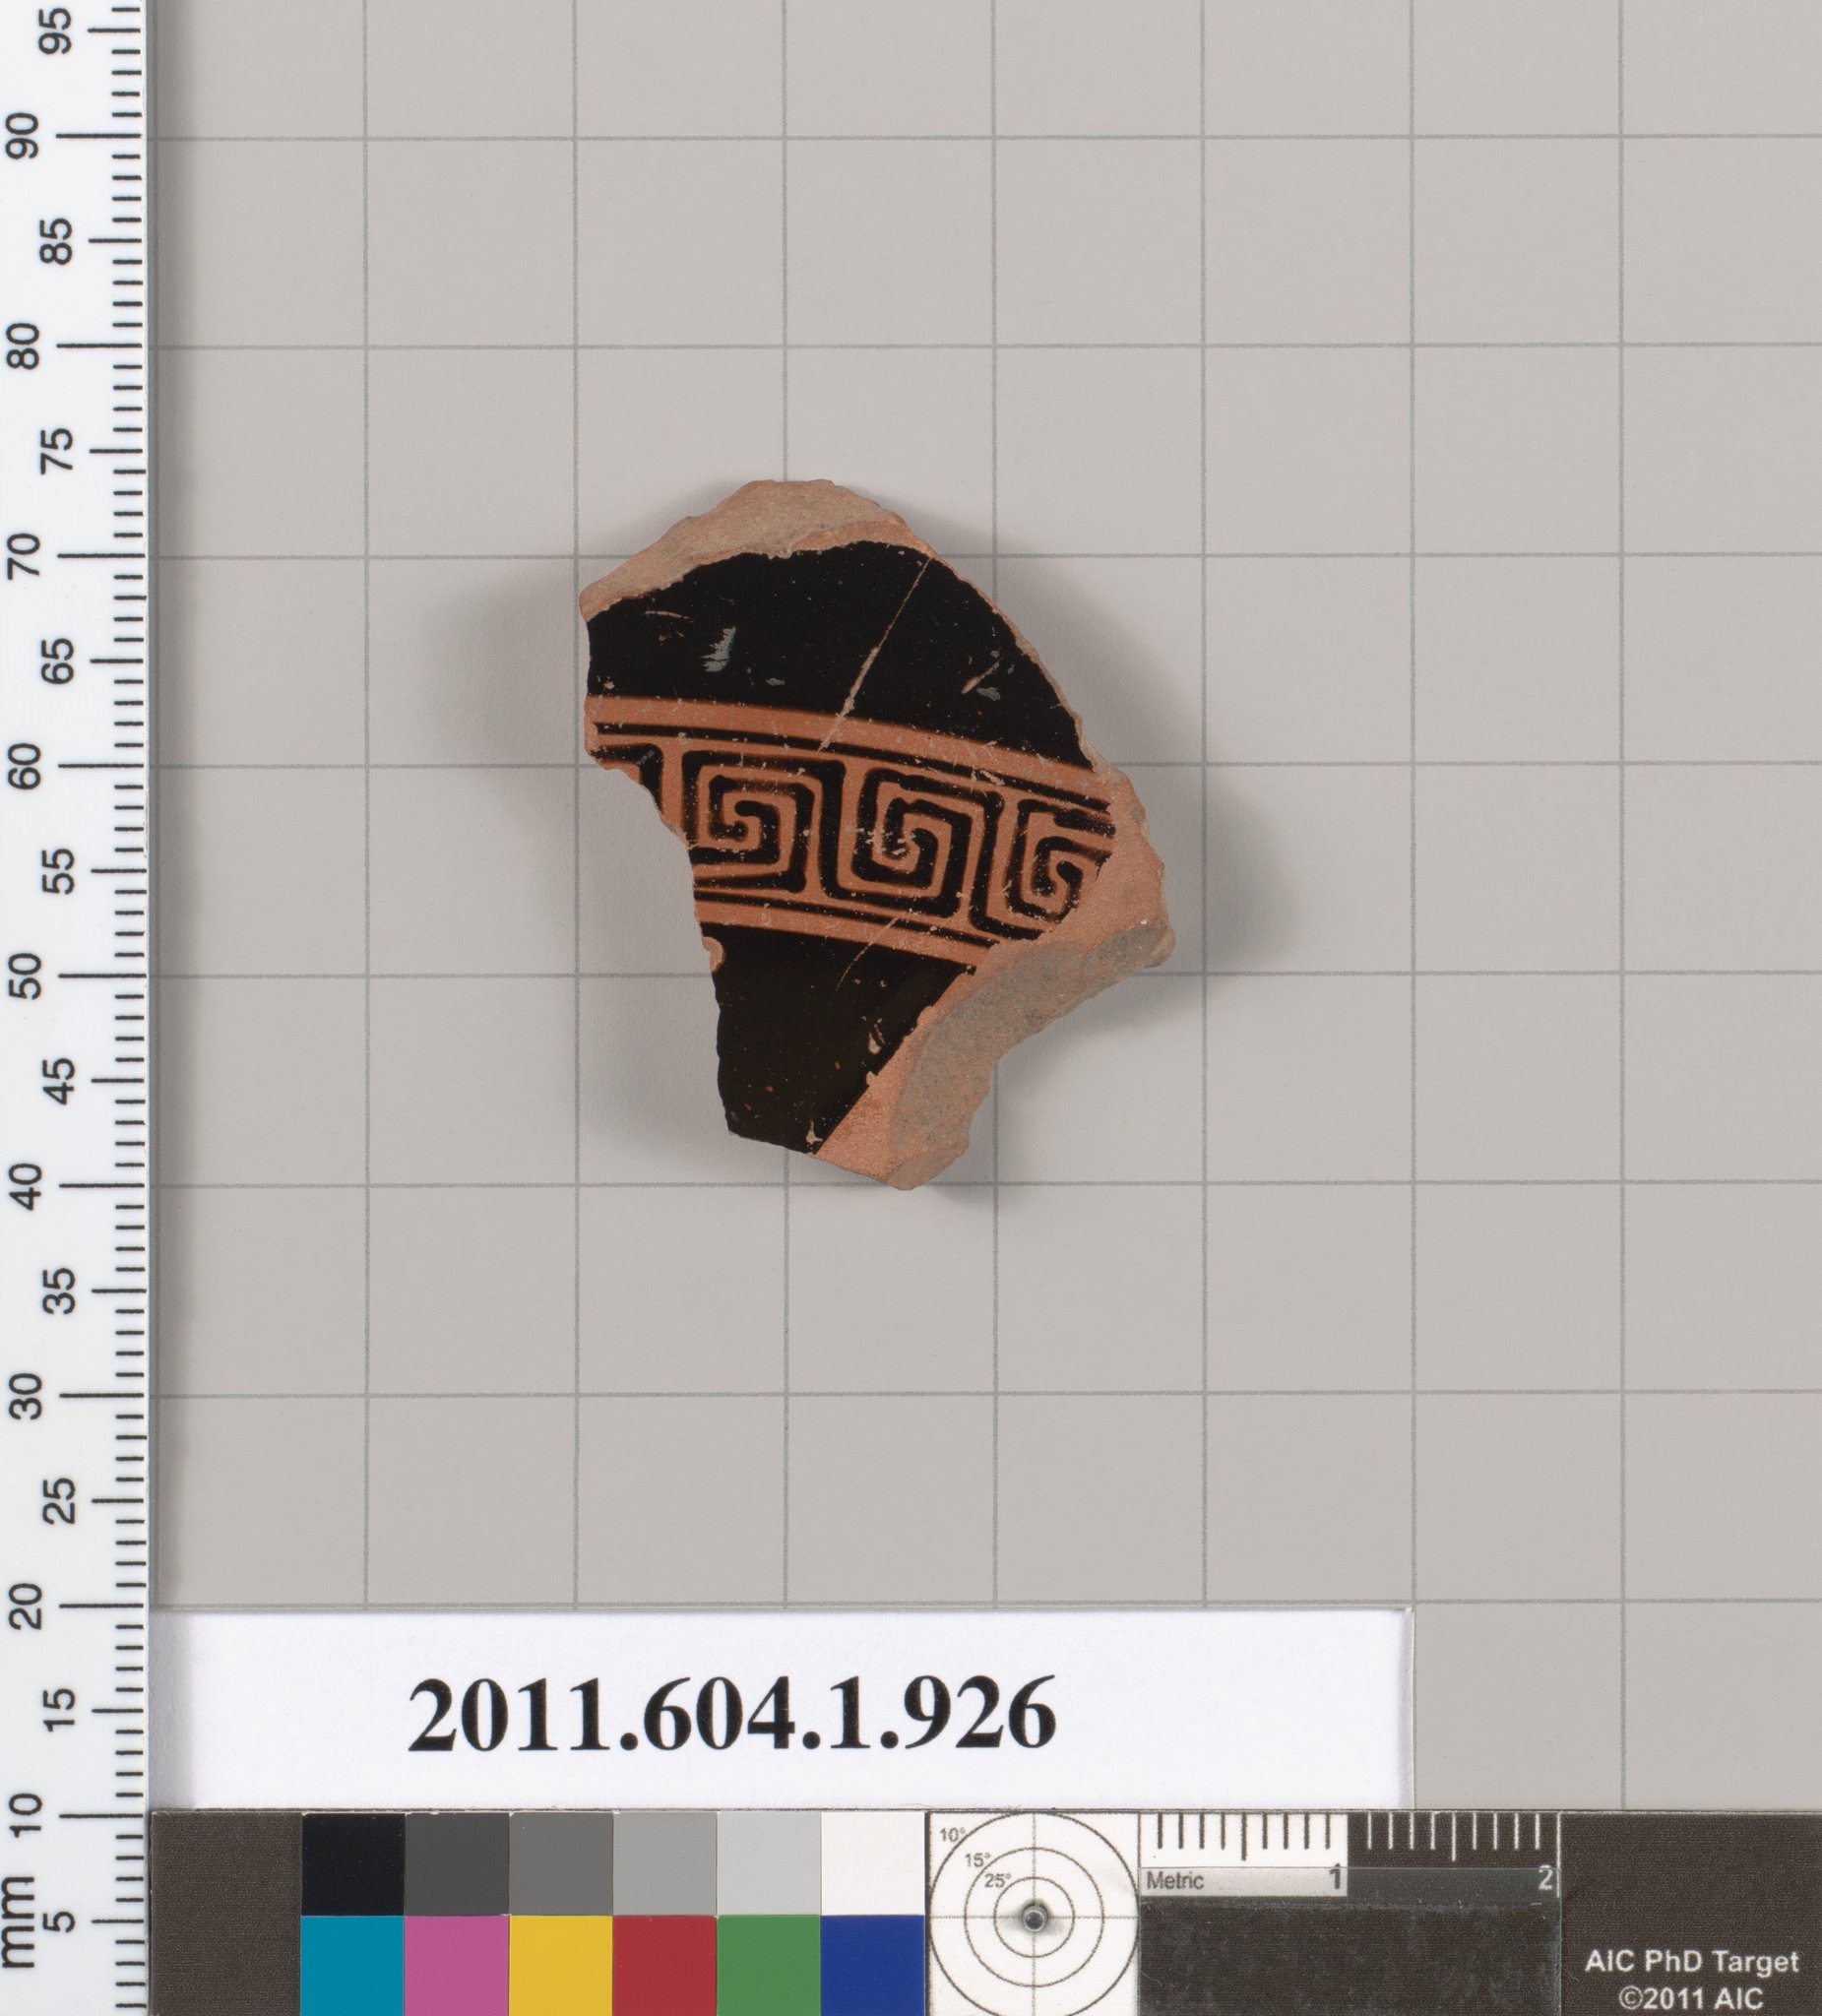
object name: kylix fragment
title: Terracotta fragment of a kylix (drinking cup)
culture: greek, attic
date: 490-480 BCE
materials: terracotta